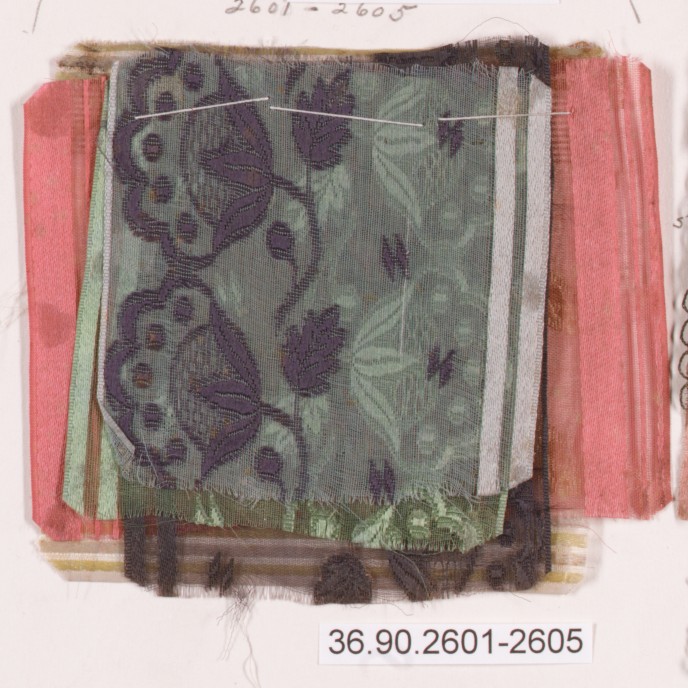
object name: ribbon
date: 1801-1900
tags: flowers